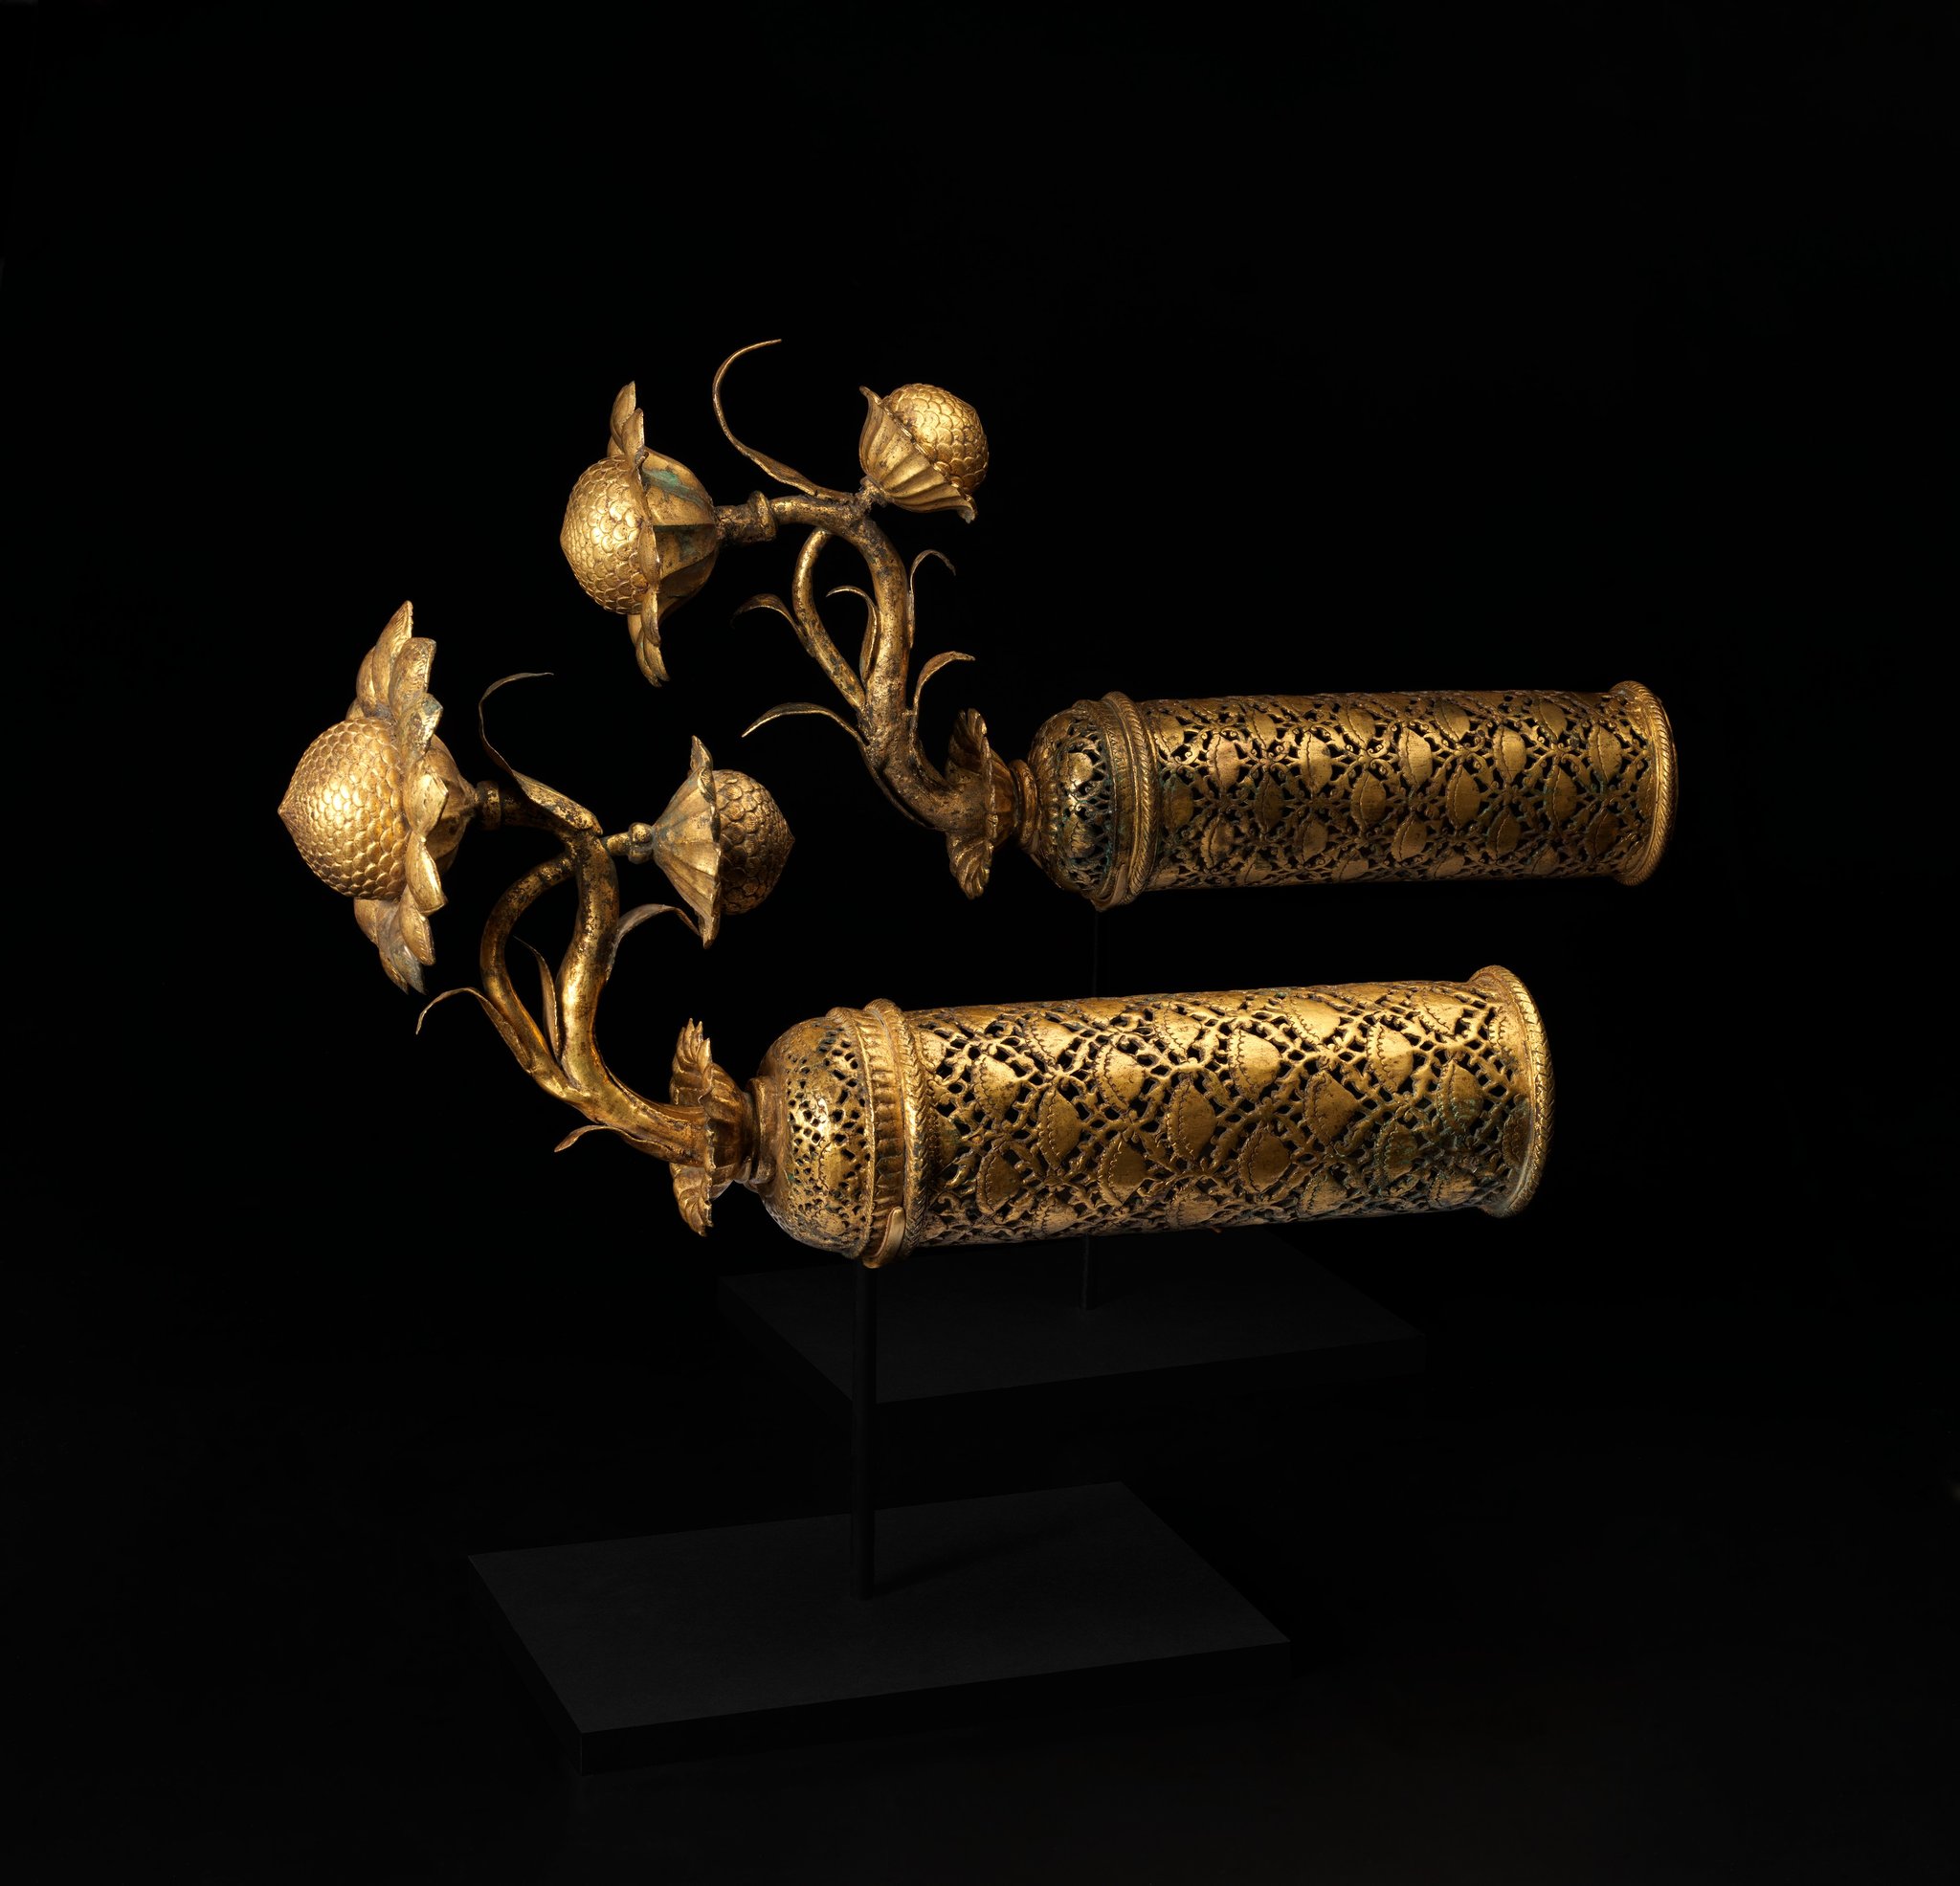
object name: finial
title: Palanquin Finials with Lotuses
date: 1650-1680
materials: copper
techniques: casting, chasing, gilding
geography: india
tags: lotuses